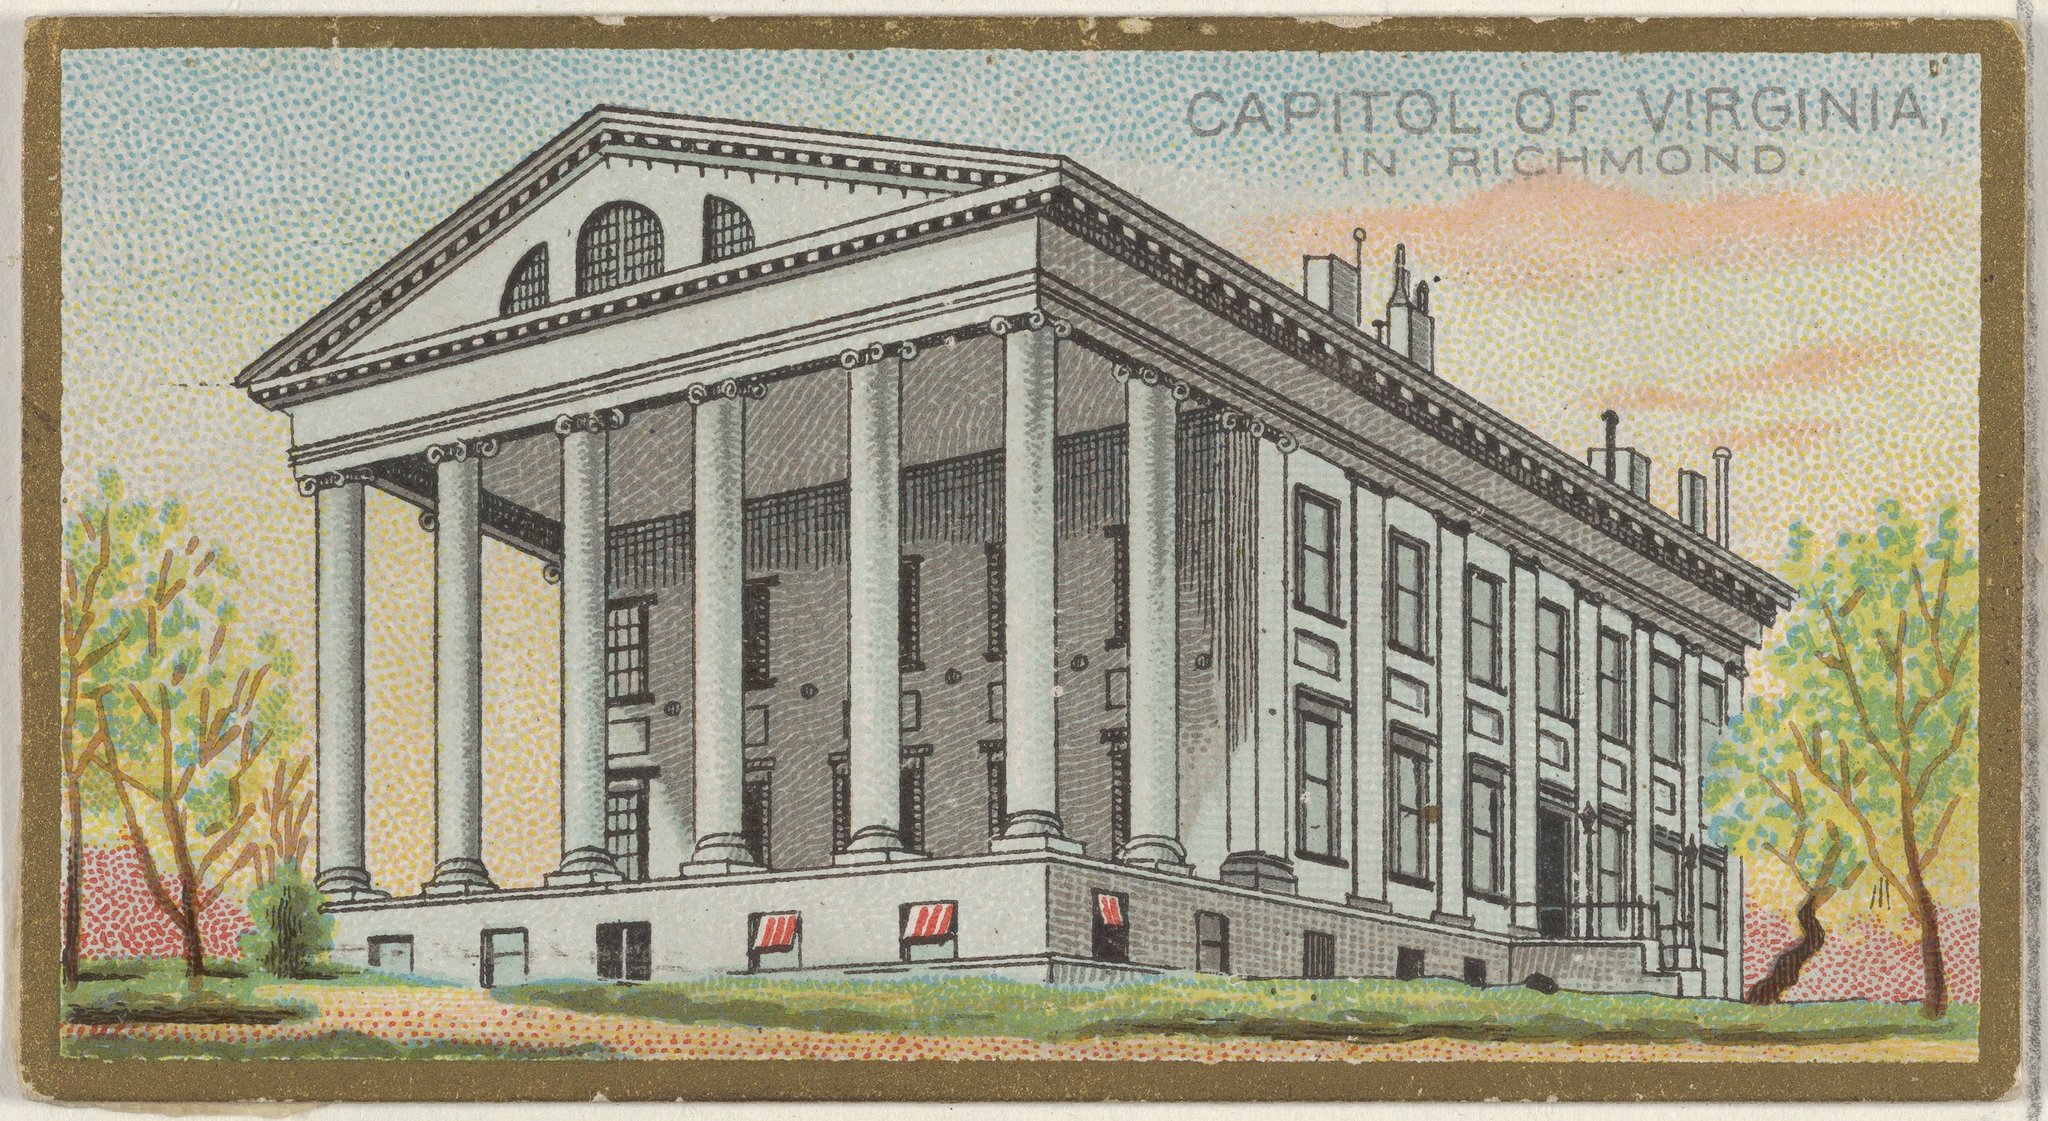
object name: print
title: Capitol of Virginia in Richmond, from the General Government and State Capitol Buildings series (N14) for Allen & Ginter Cigarettes Brands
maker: allen & ginter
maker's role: publisher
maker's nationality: american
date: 1889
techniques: color lithograph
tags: buildings